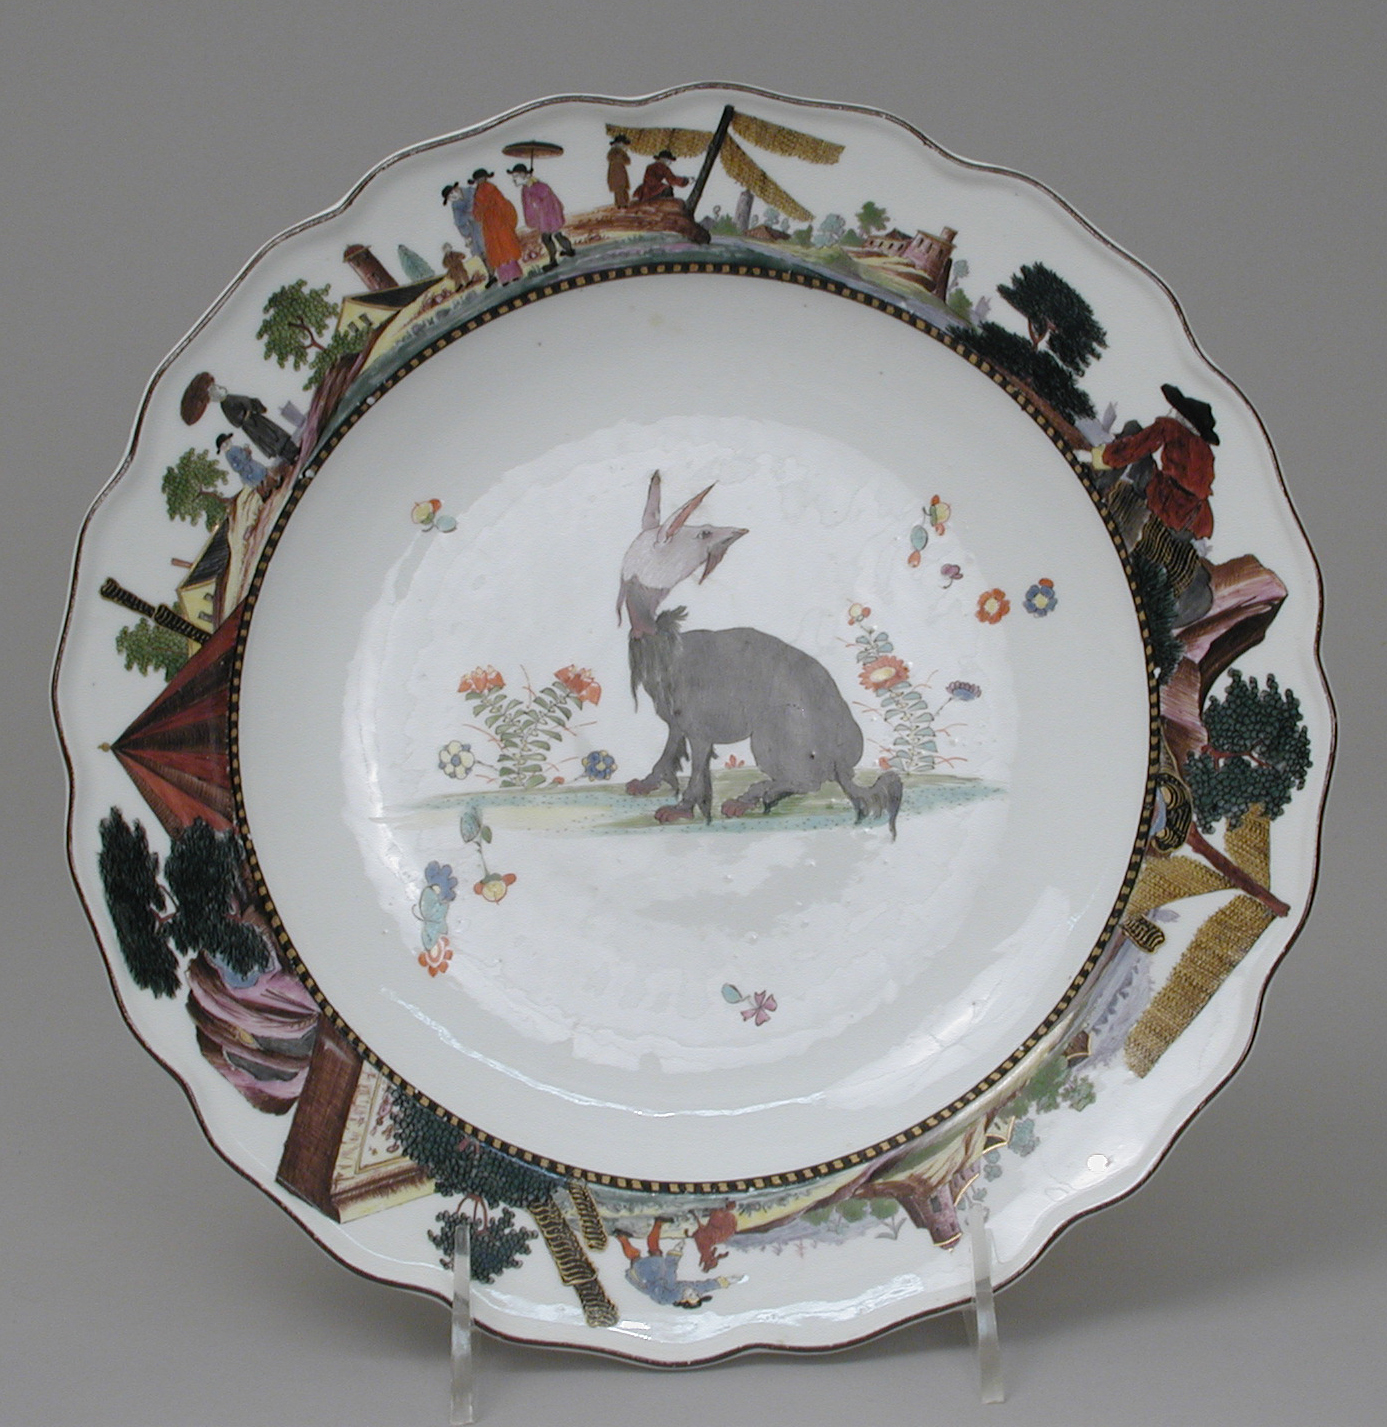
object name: plate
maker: meissen manufactory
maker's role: manufactory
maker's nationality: german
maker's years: 1710-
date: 1740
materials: hard paste porcelain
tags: human figures,animals